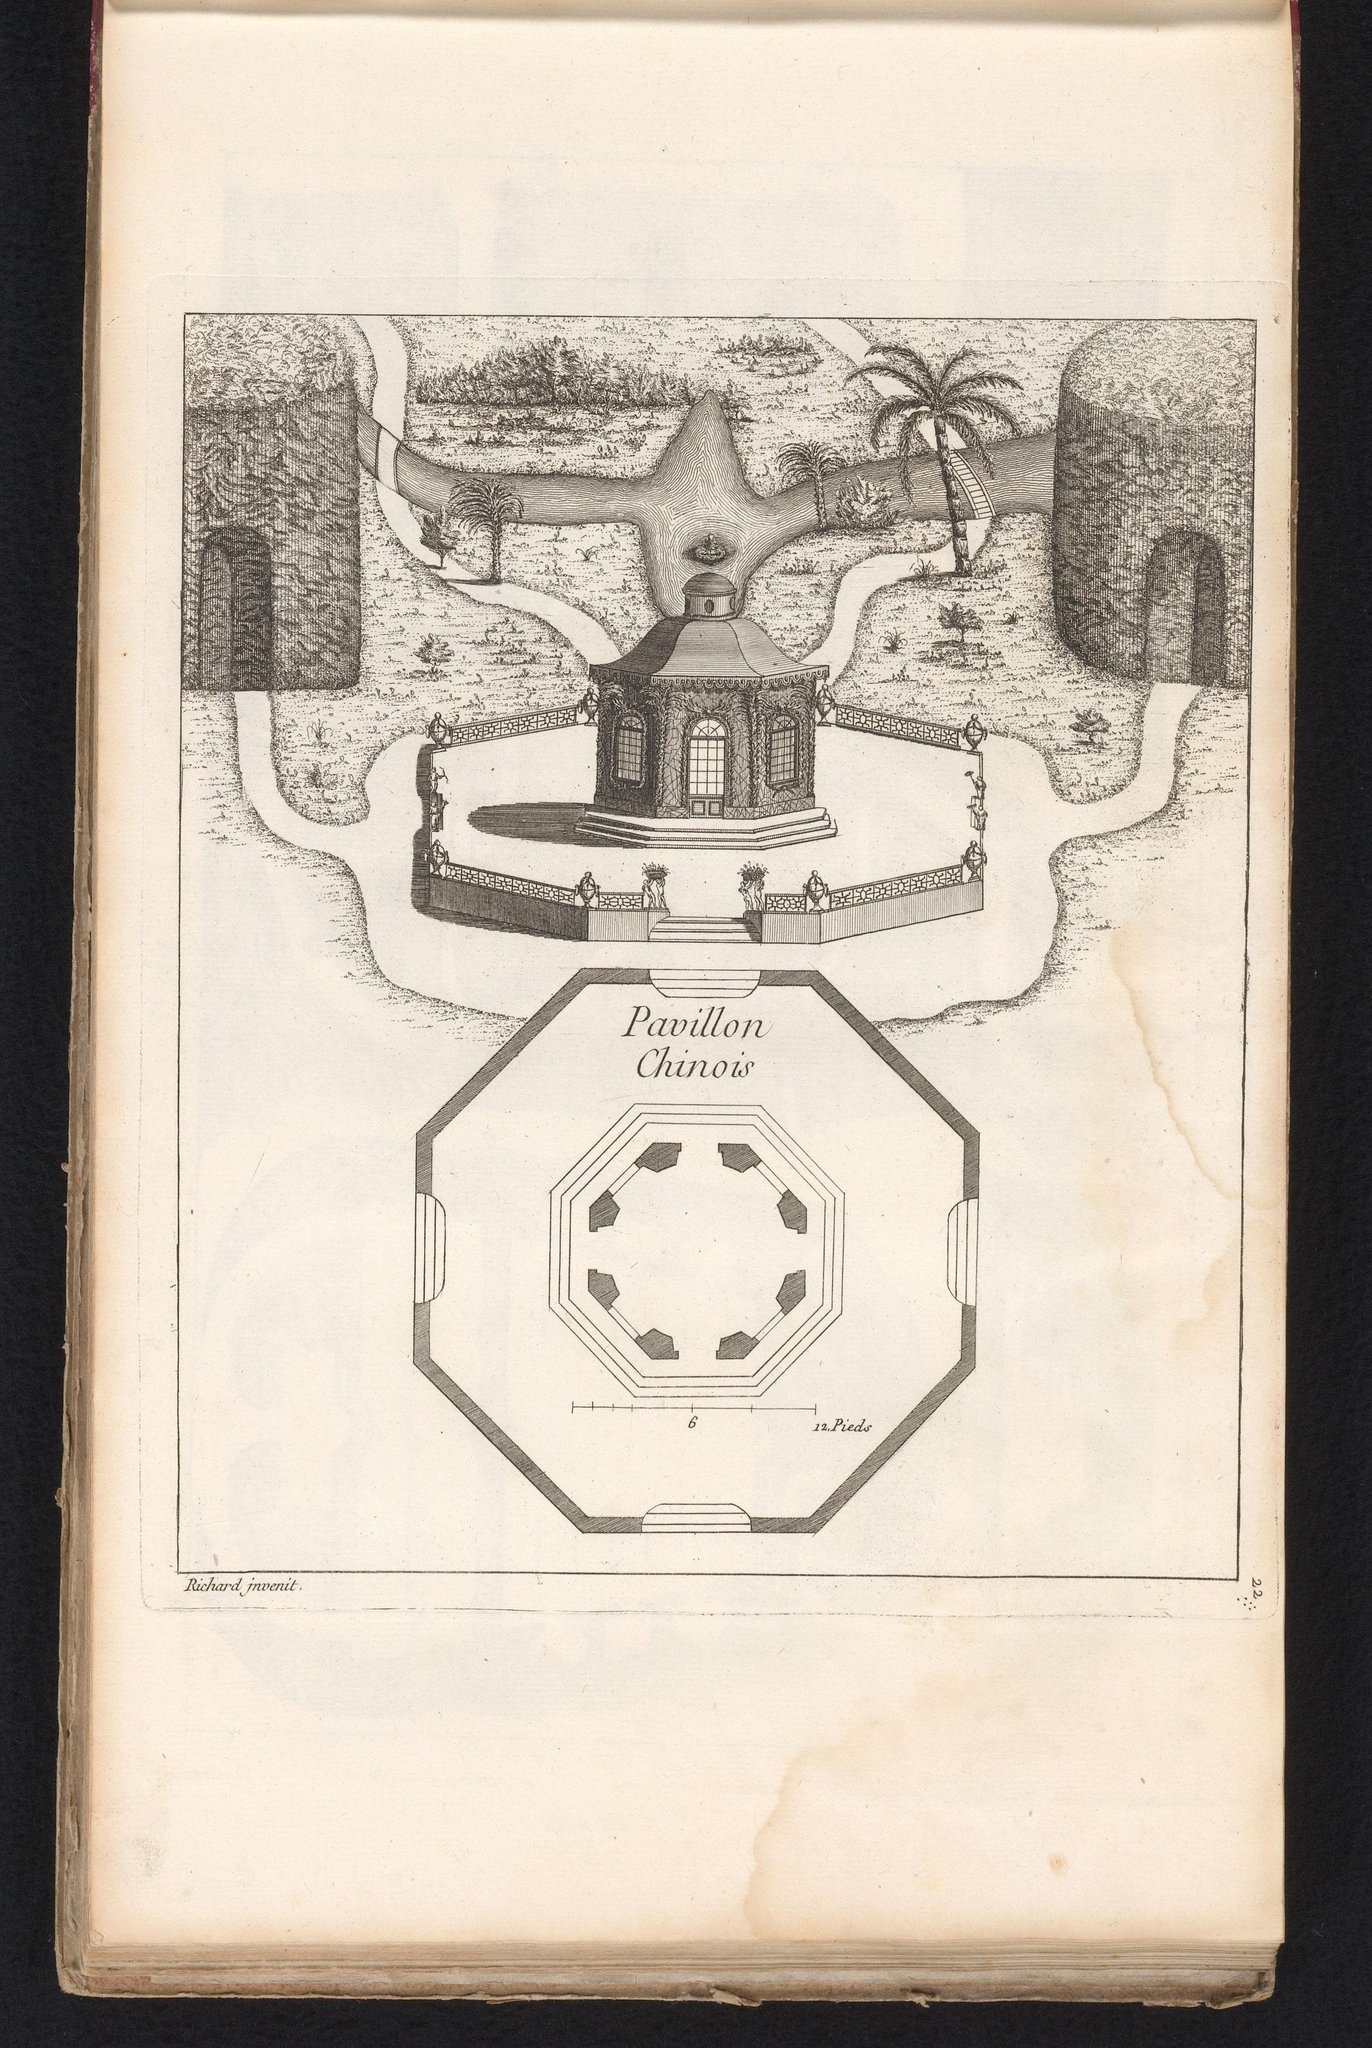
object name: print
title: Jardins anglo-chinois à la mode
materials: paper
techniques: engraving, etching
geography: paris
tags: summer-house, arbour, garden-house (dutch: 'theekoepel'), lay-out of garden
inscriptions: collector's mark: Lugt 2228, collector's mark: Lugt 2760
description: De serie 'Jardins anglo-chinois à la mode' verscheen in totaal in 21 zogeheten 'cahiers' (afleveringen). De huidige prent komt uit het zesde 'cahier'. Het Rijksmuseum Amsterdam bezit drie banden met daarin in totaal zes 'cahiers' van deze reeks. In de documentatie wordt verwezen naar een in de bibliotheek van het Rijksmuseum Amsterdam aanwezige facsimile van het complete werk.